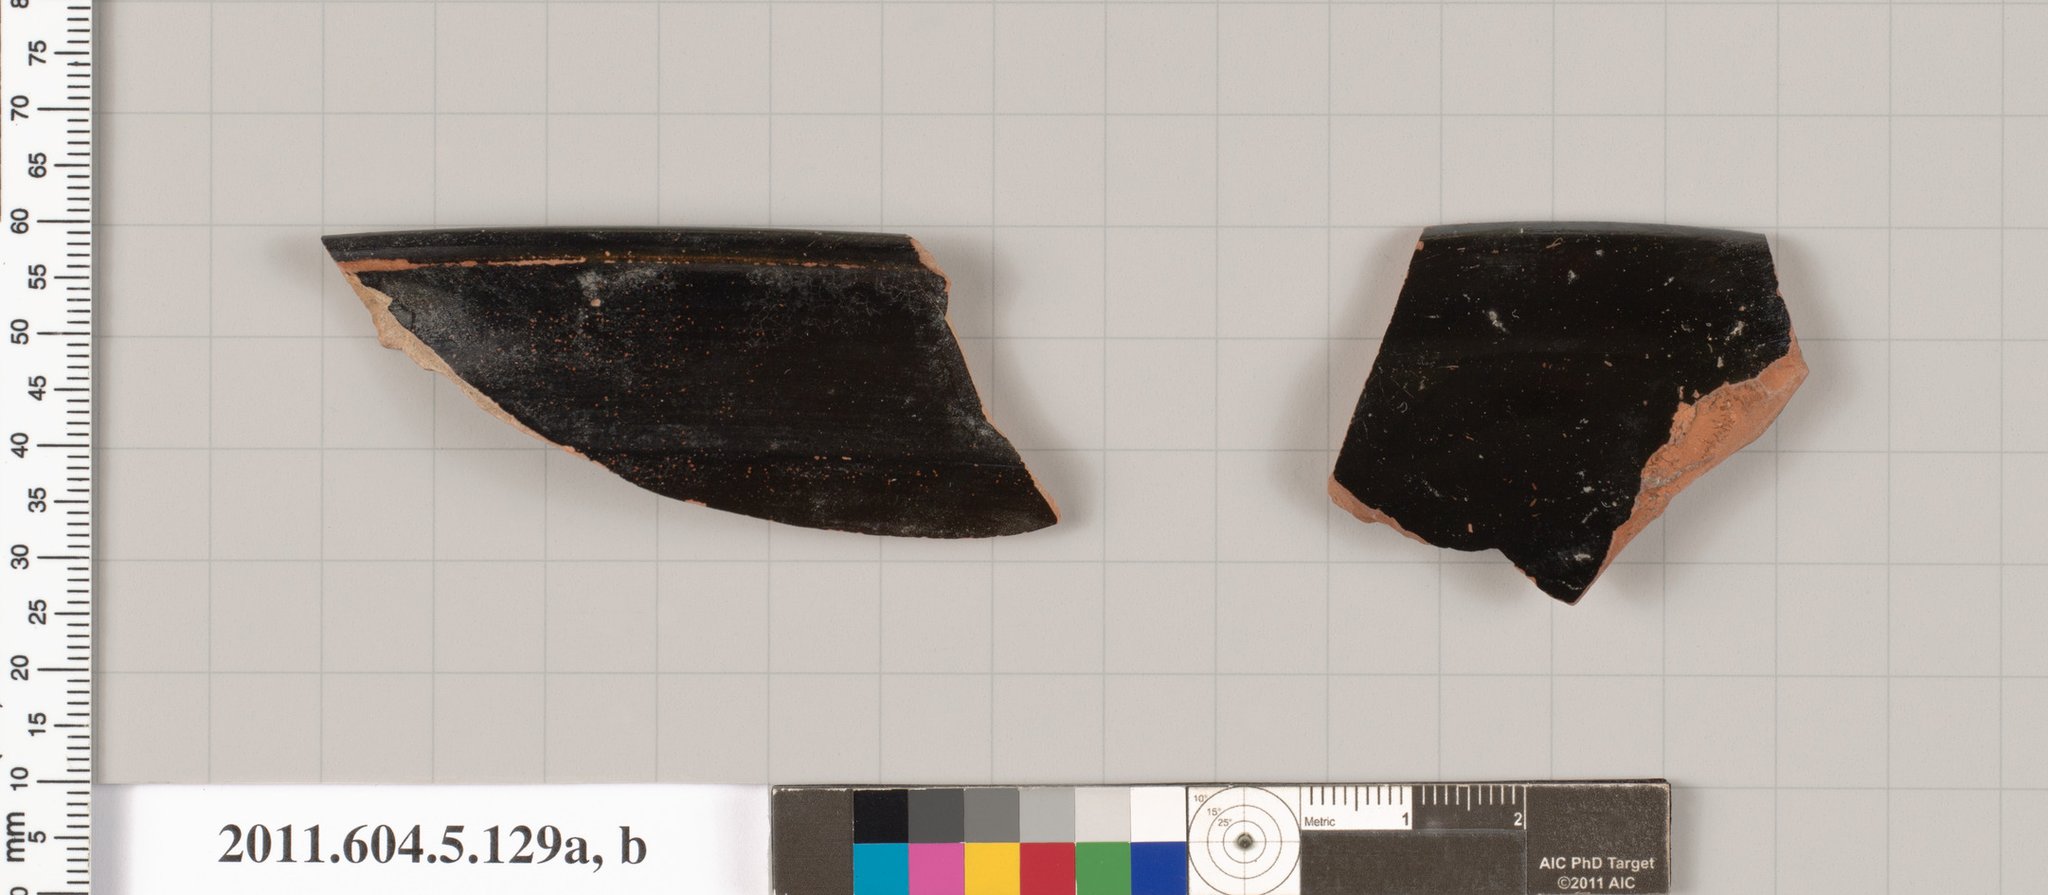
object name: kylix fragment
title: Terracotta rim fragments of stemless kylikes (drinking cups)?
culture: greek, attic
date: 470-450 BCE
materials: terracotta